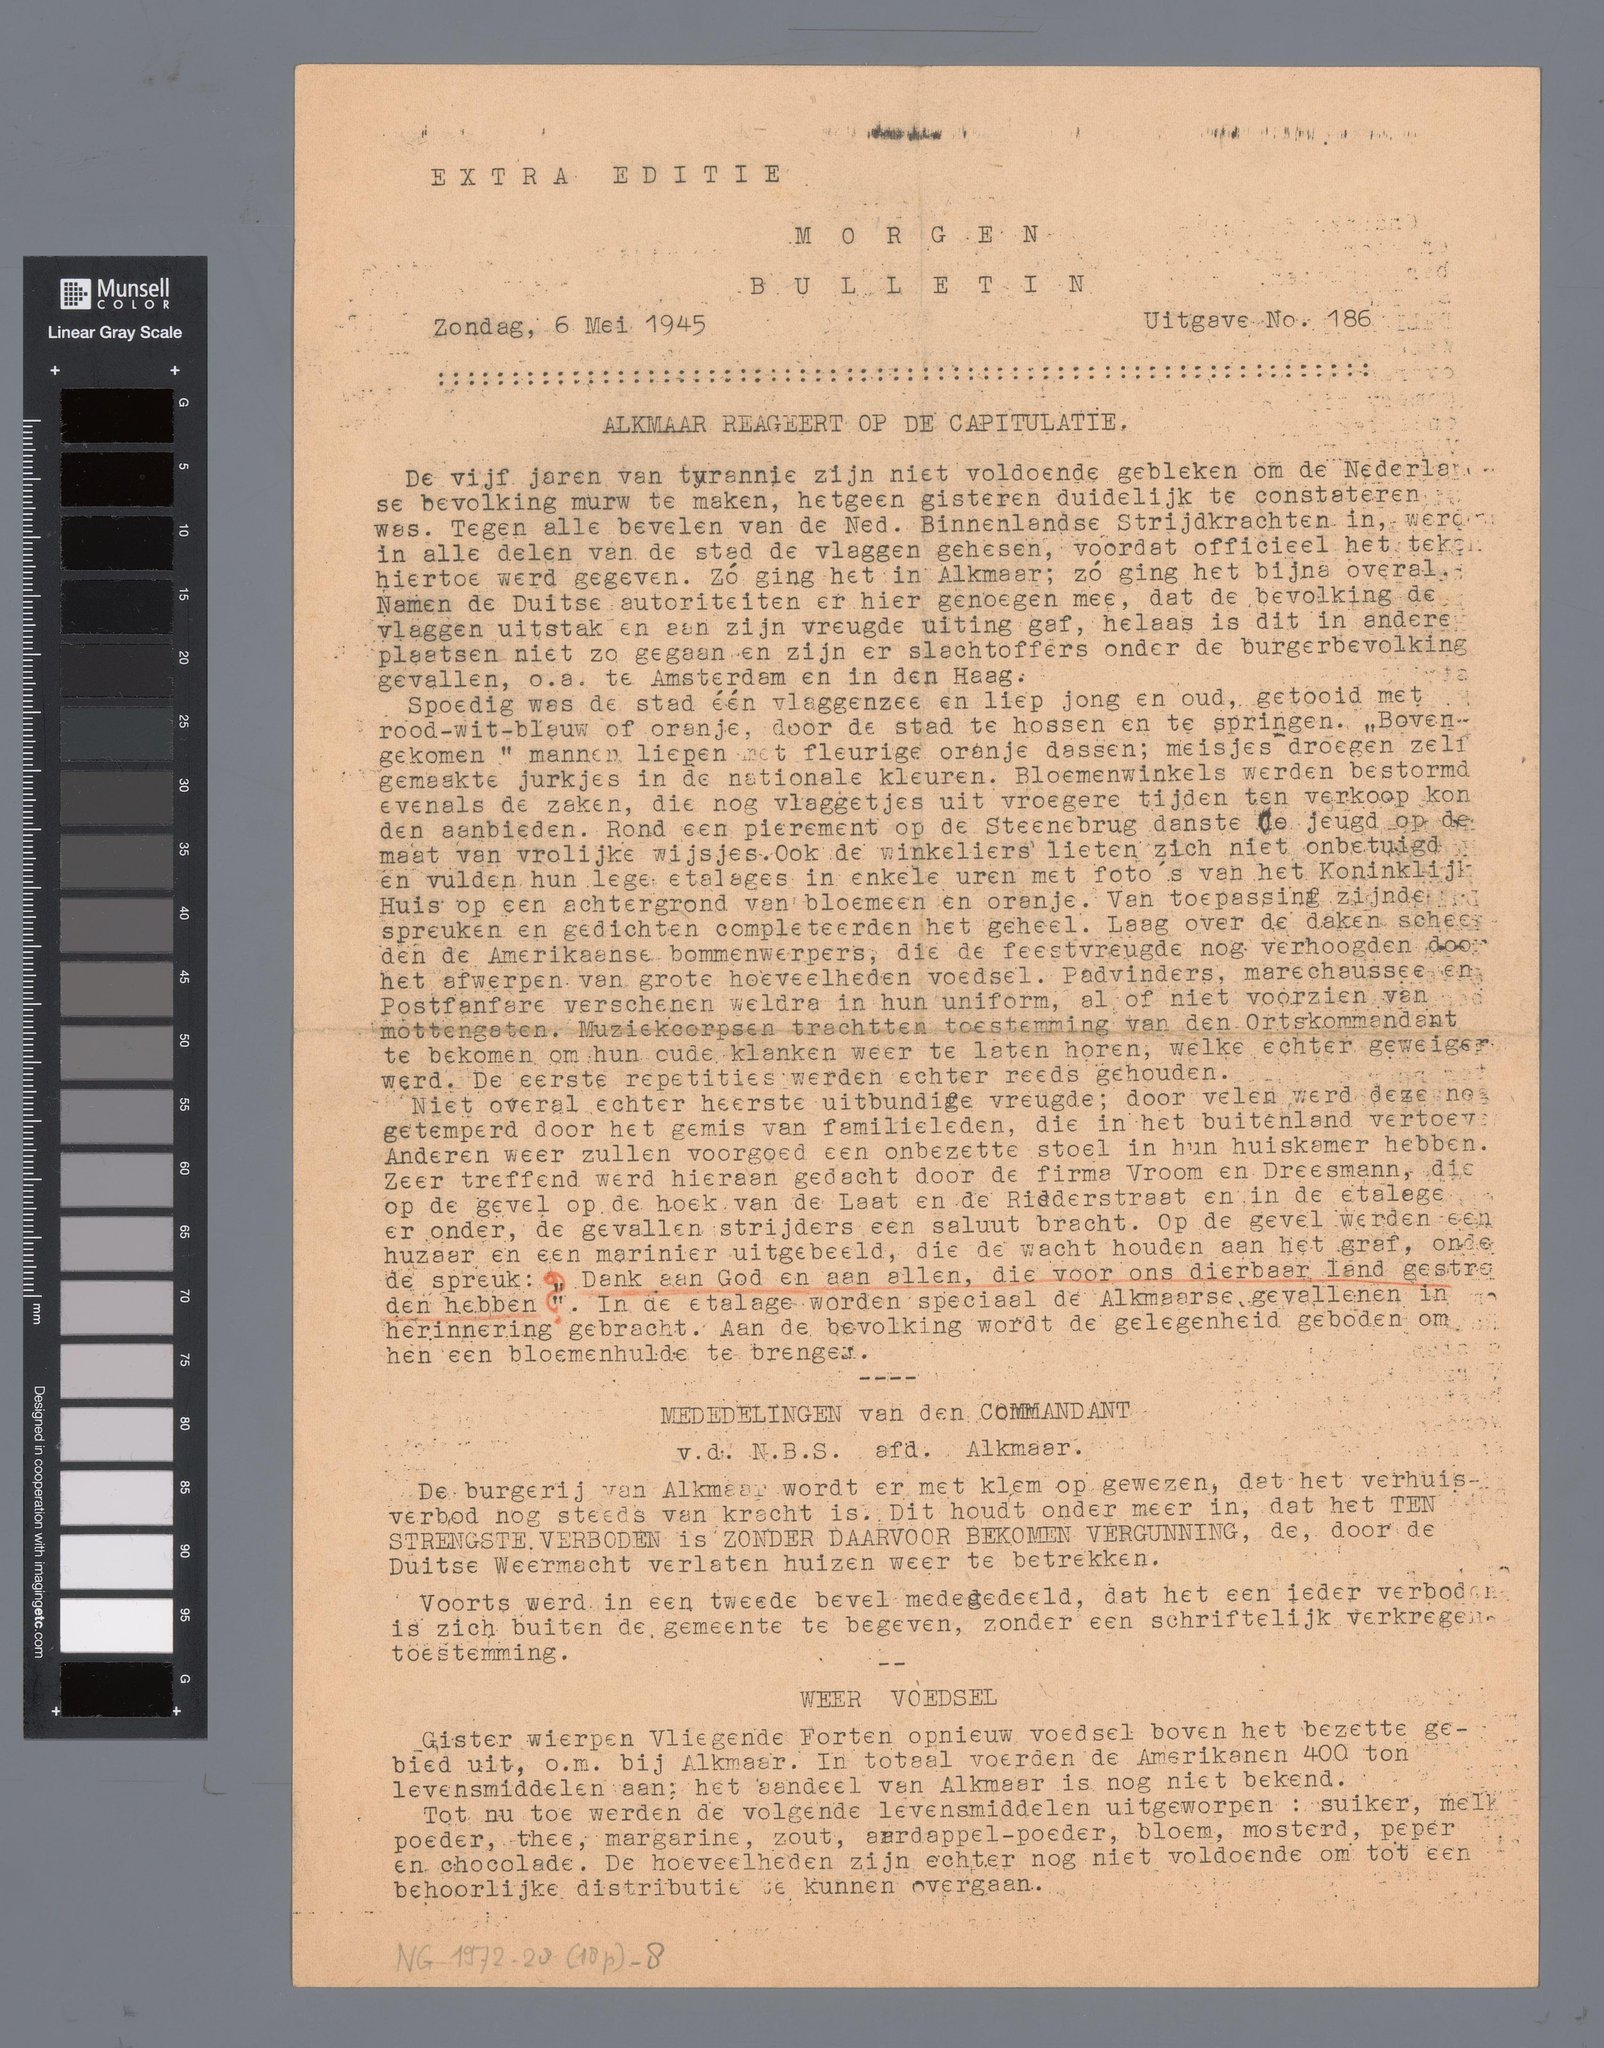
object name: sheet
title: Morgen Bulletin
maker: p. duyff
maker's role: schrijver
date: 1945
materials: paper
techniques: mimeography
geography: alkmaar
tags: europe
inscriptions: date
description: Nummer van illegaal blad Morgen bulletin, 1ste jaargang, nr. 186, 6/5/1945, 2 pp, (Alkmaar reageert op de capitulatie). Gedateerd: r.b.